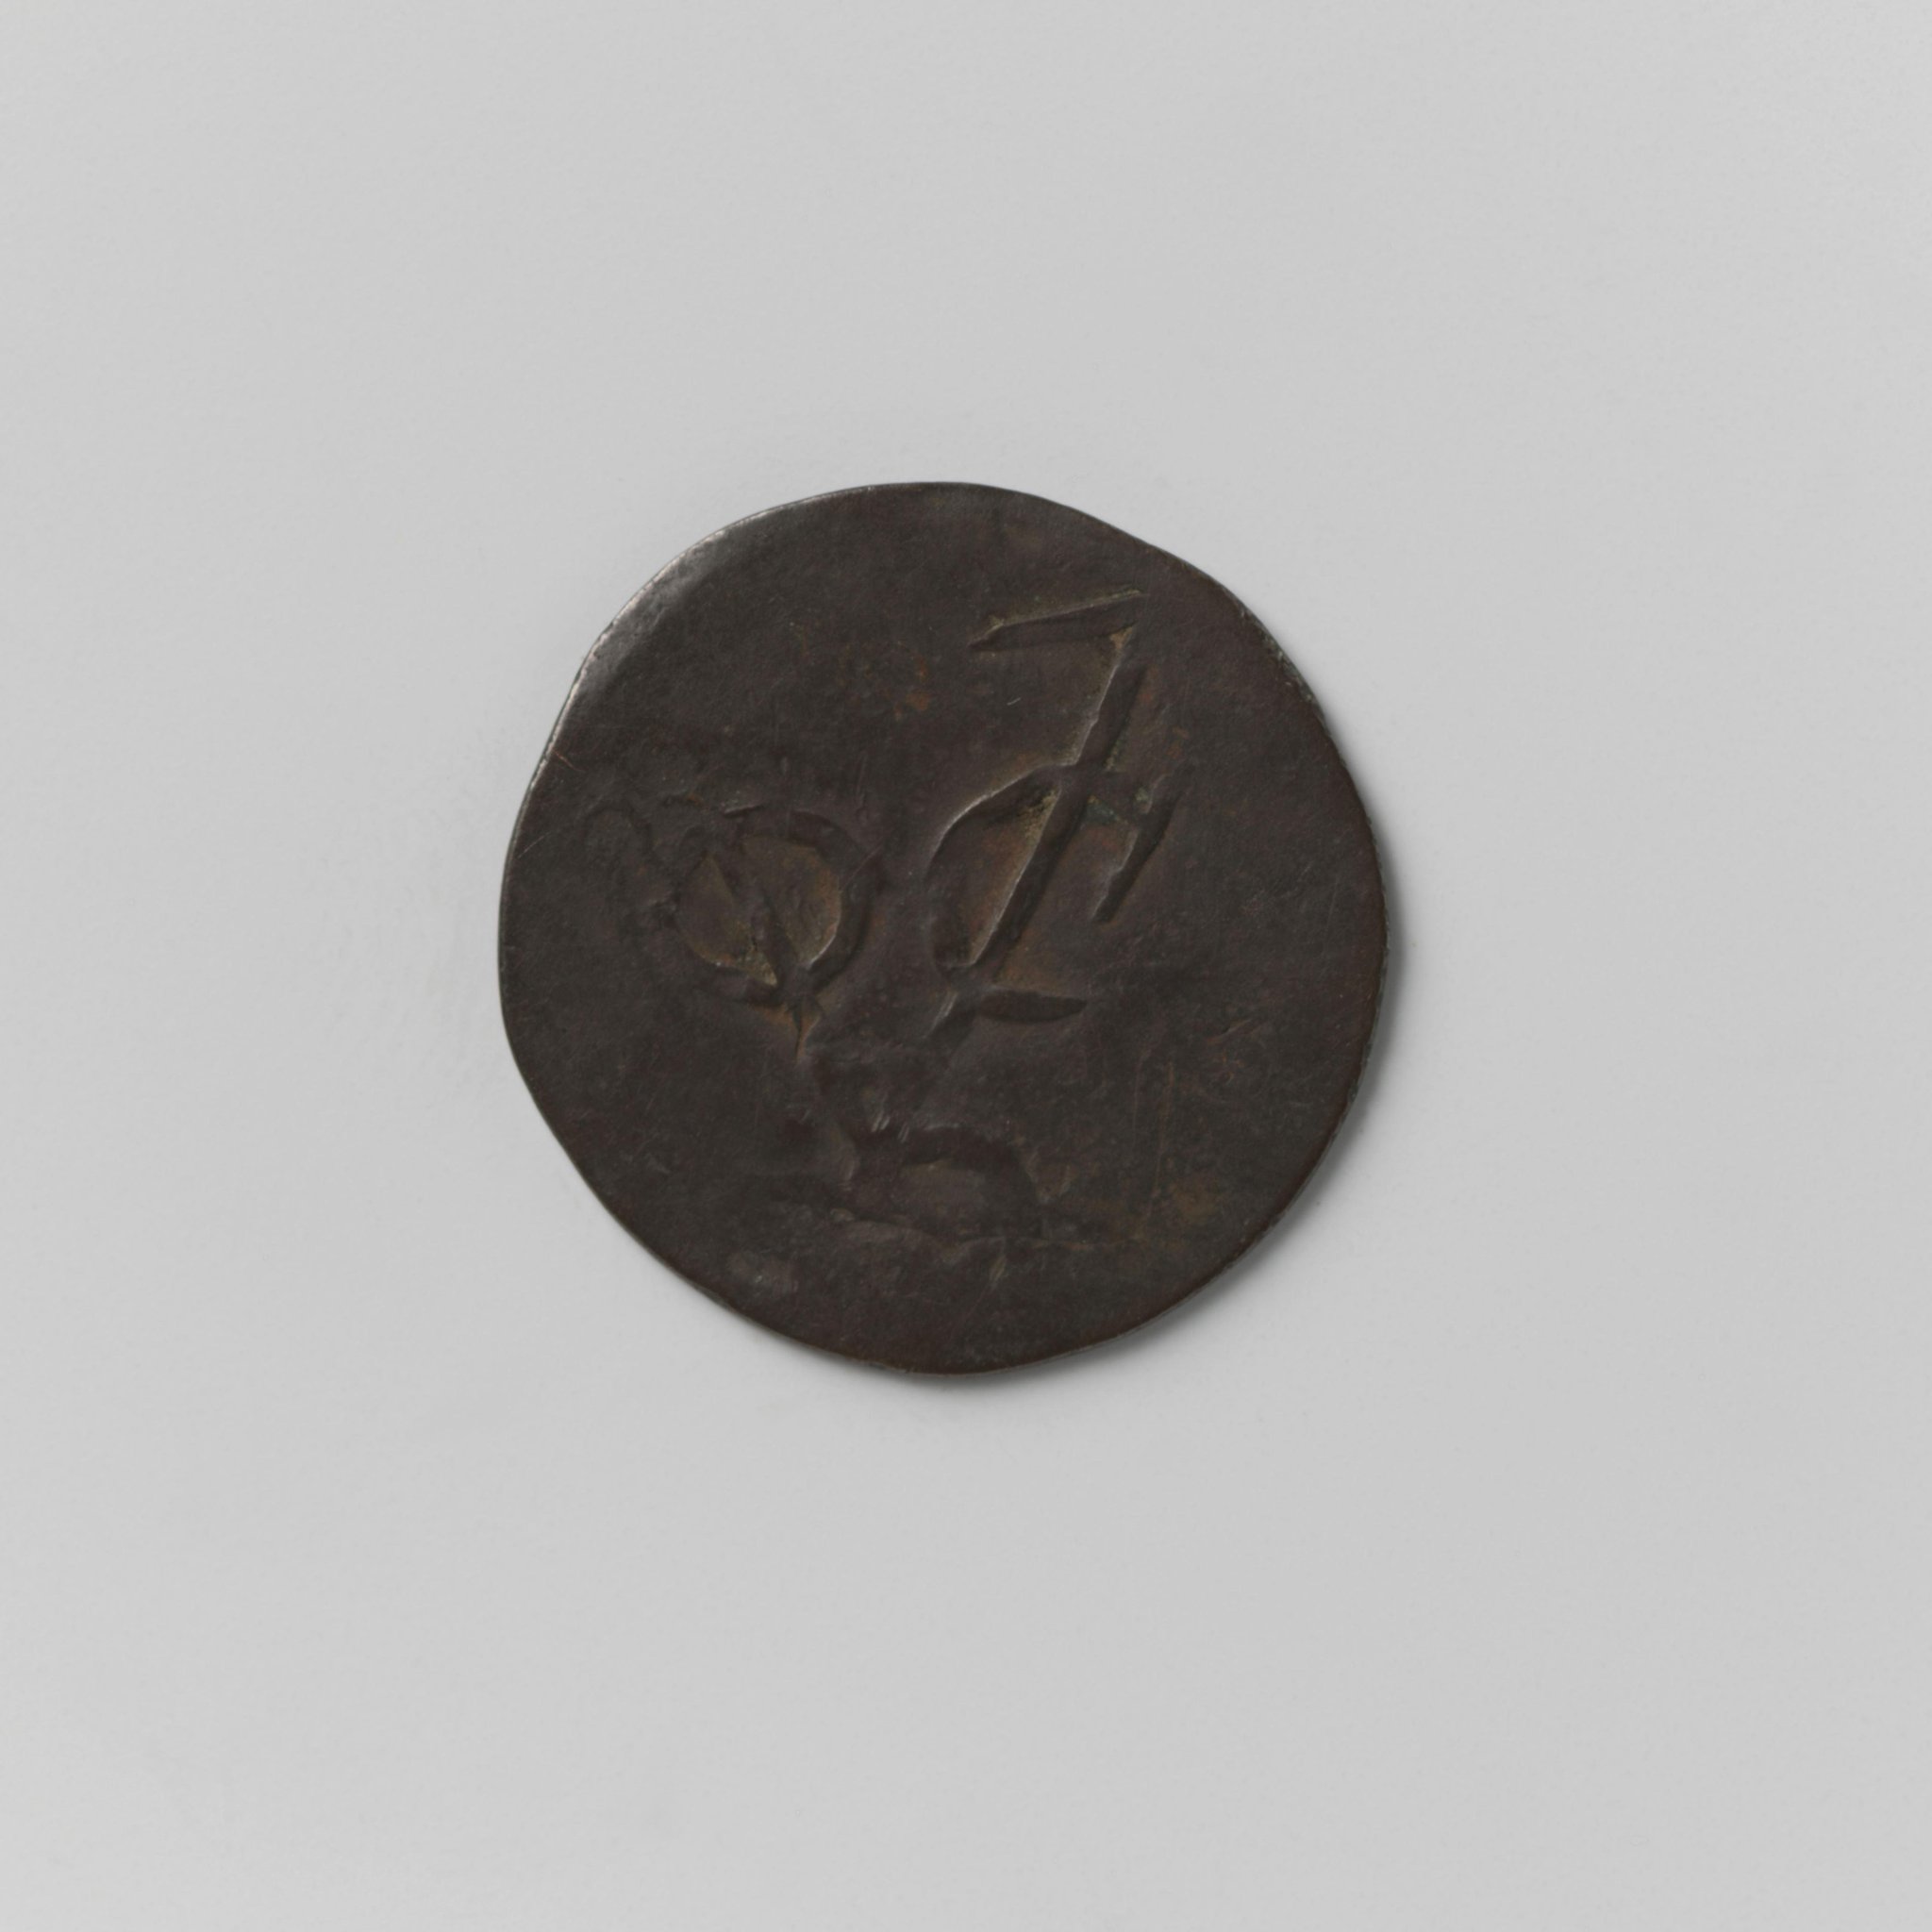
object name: coin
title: Nabootsing van VOC- duit Zeeland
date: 1780-1830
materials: copper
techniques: striking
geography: banjarmasin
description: Koperen munt. Nabootsing van duit van de VOC uit Zeeland. Voorzijde: gekroond wapenschild van Zeeland. Keerzijde: monogram van de VOC, waaronder fictief jaartal.